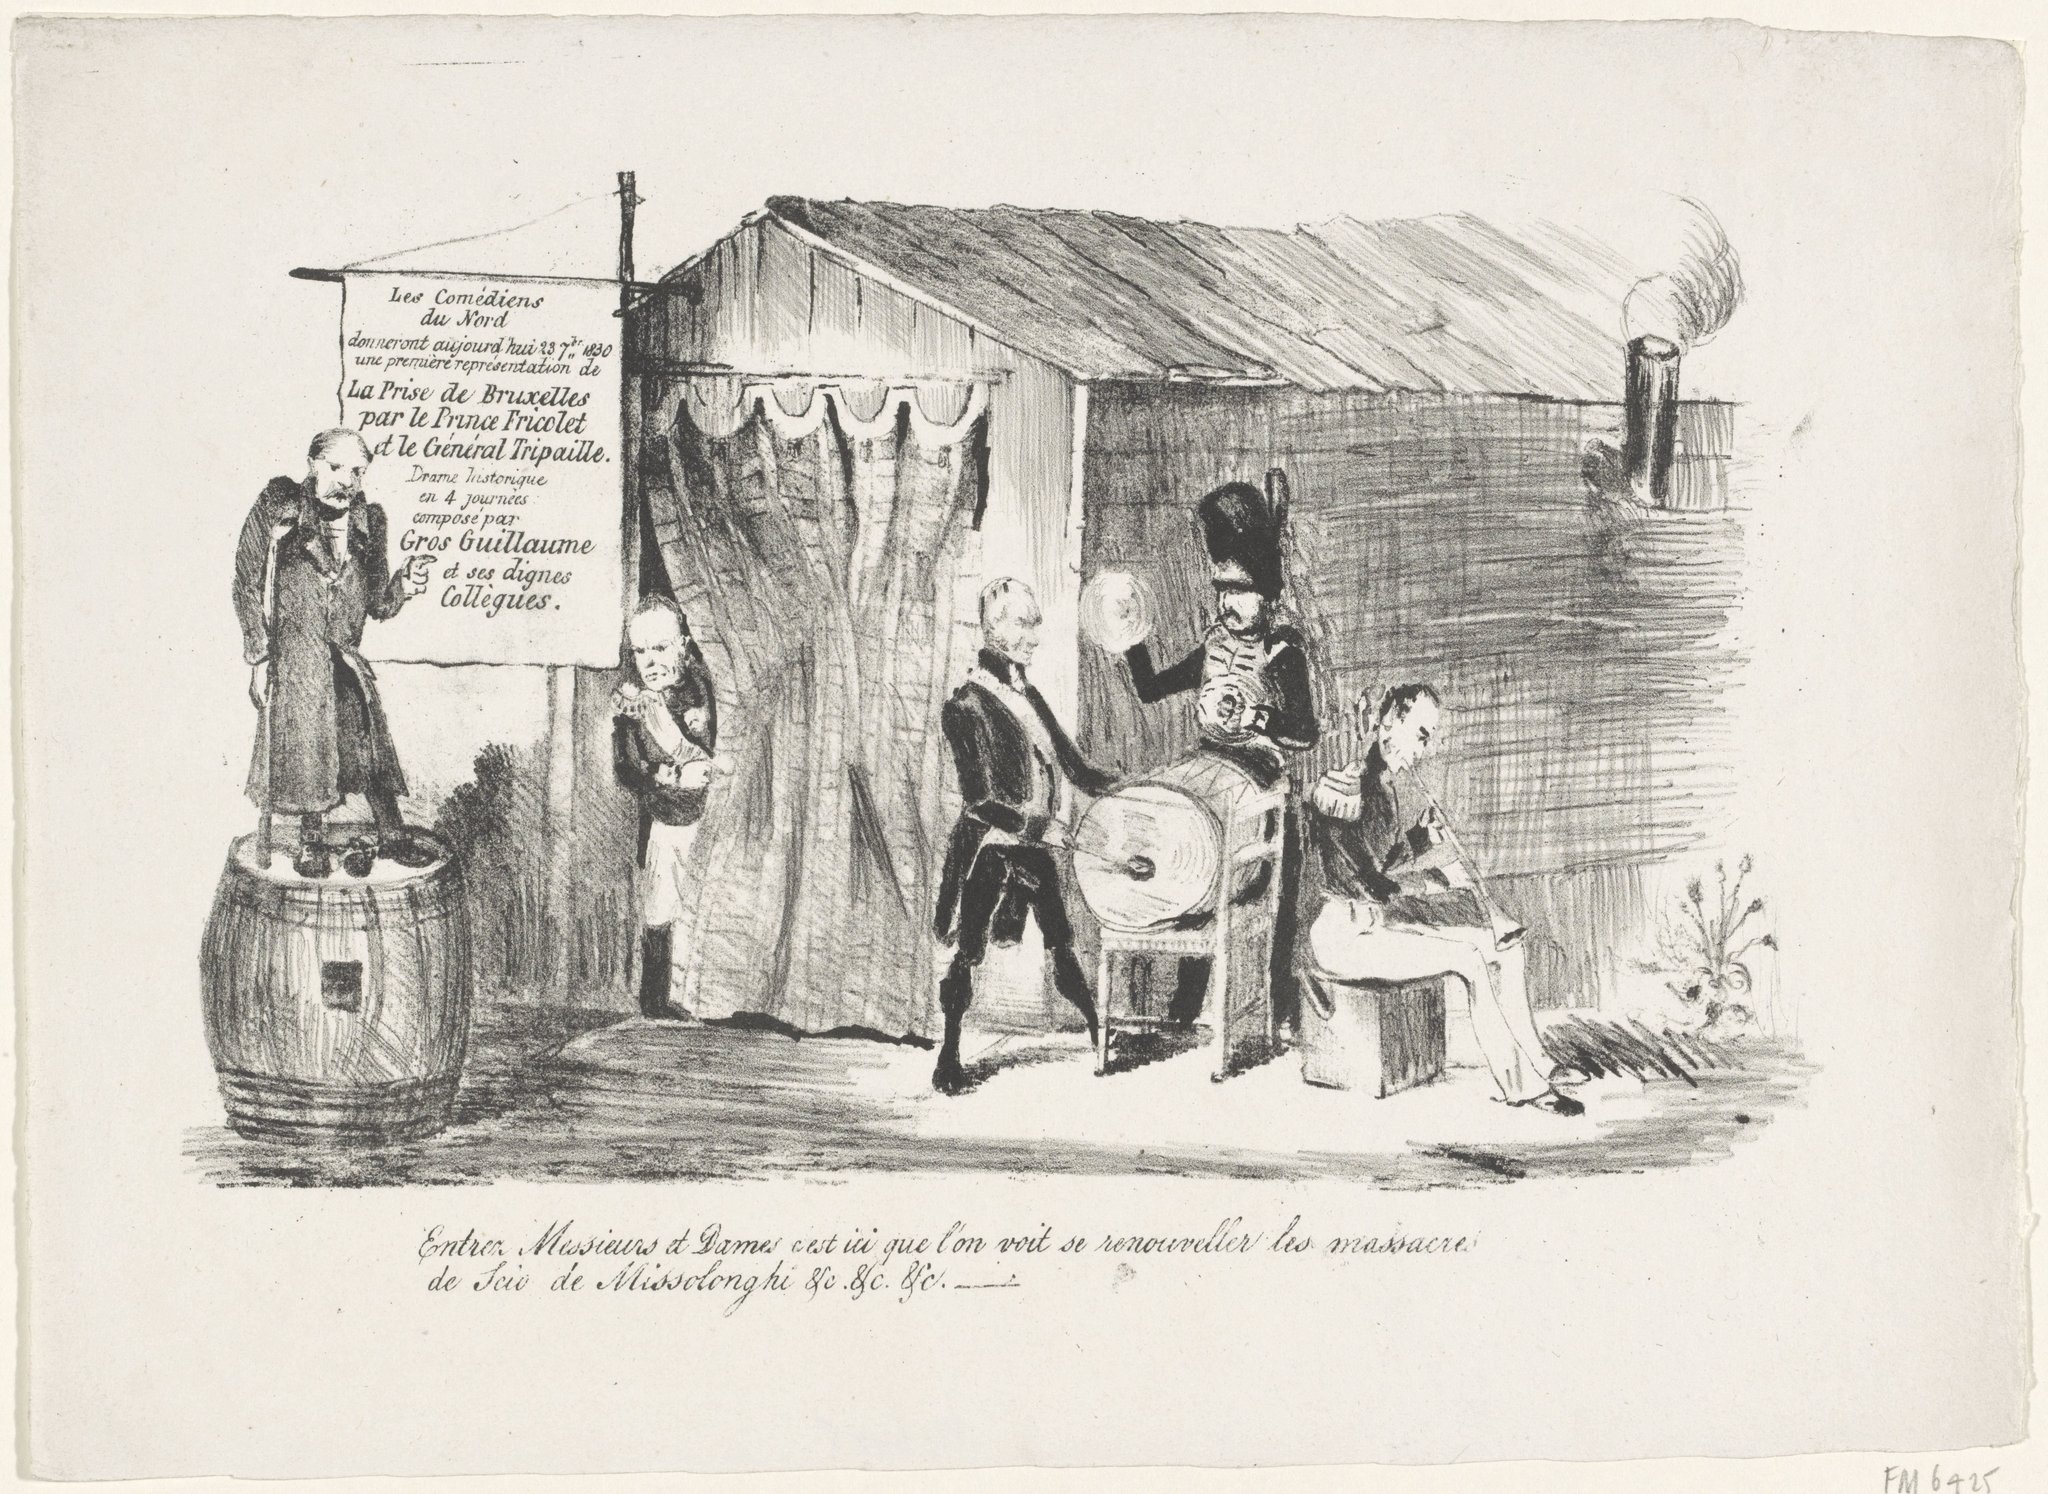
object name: cartoon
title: Spotprent op Nederlandse acties tegen de opstand, 1830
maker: Anonymous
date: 1830-1831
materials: paper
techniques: lithograph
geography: belgium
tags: the hague, berlin, william i of the netherlands, printer, publisher, frederik (prins der nederlanden), troupe (actors) 'en route', pleasure fair and circus, brussels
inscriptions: collector's mark: Lugt 2228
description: Spotprent op de pogingen van de Nederlandse troepen om de Belgische opstand in Brussel te onderdrukken, 23-26 september 1830. Nederlanders voorgesteld als een rondreizend circusgezelschap. Voor een tent maakt de uitgever Libry reclame voor het optreden, koning Willem I kijkt even vanachter de gordijnen naar buiten. Rechts prins Frederik, minister Van Maanen en generaal Trip als muzikanten. Aan een vaandel de aankondiging van het optreden van de 'Comédiens du Nord' met het stuk 'La Prise de Bruxelles par le Prince Fricolet et le Général Tripaille'.